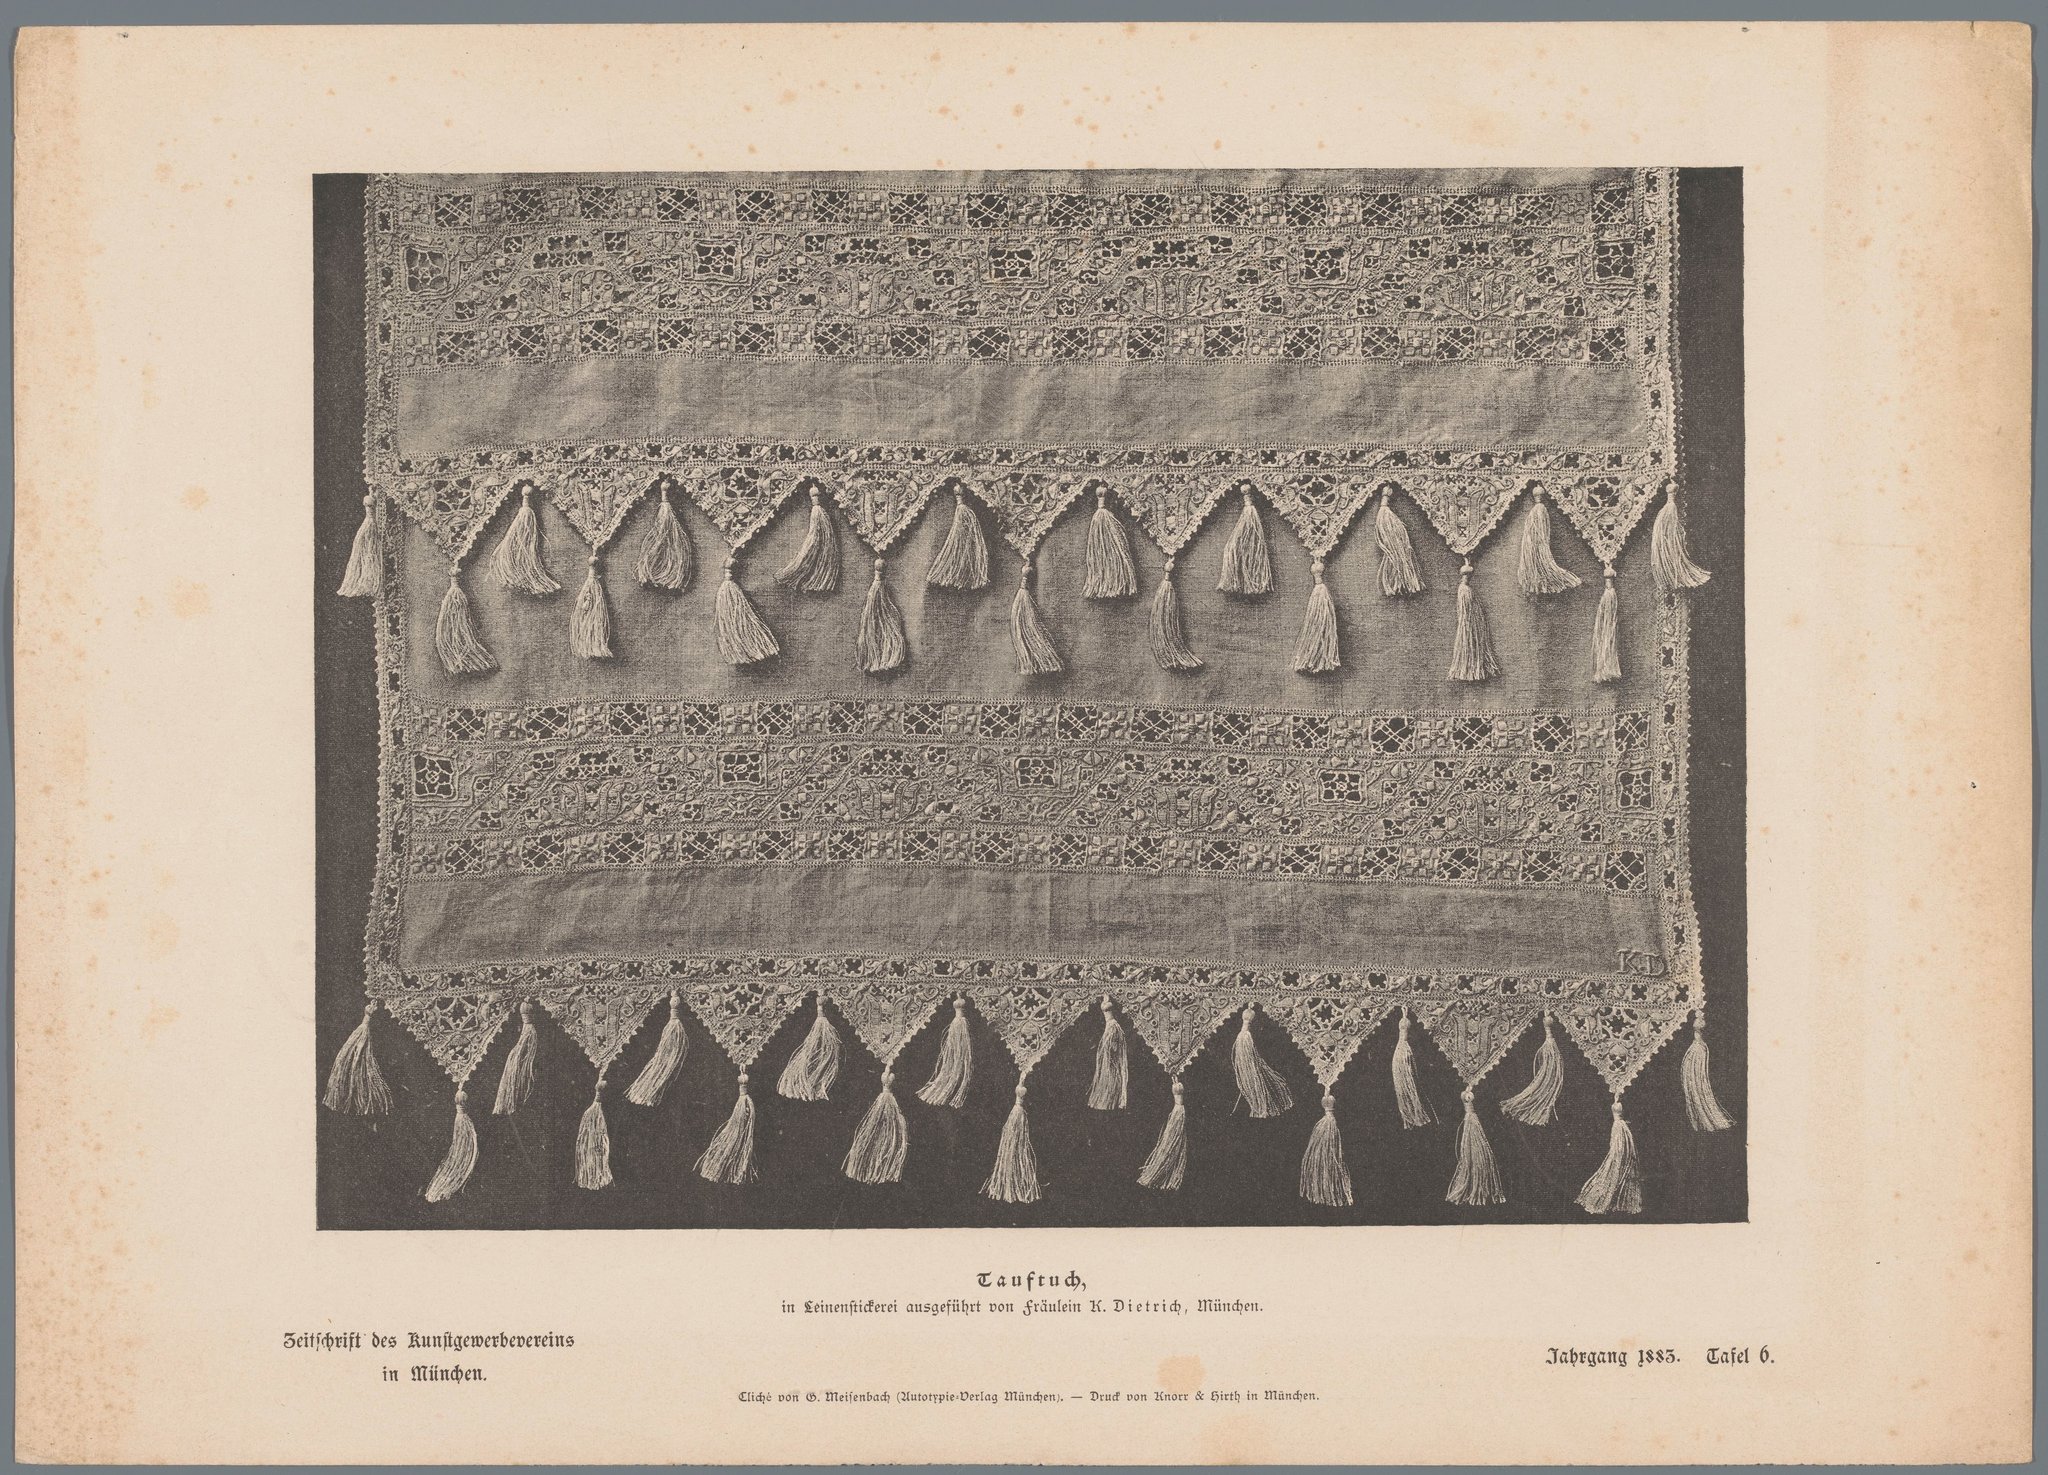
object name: photograph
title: NAPOLI - Museo Nazionale. Perseo e Andromeda. (Pompei.)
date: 1875-1900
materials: cardboard, photographic support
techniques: albumen print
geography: naples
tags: perseus and andromeda, picture, painting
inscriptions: collector's mark: Lugt 3937, number: ‘P.e 2.a N.o 12034.’